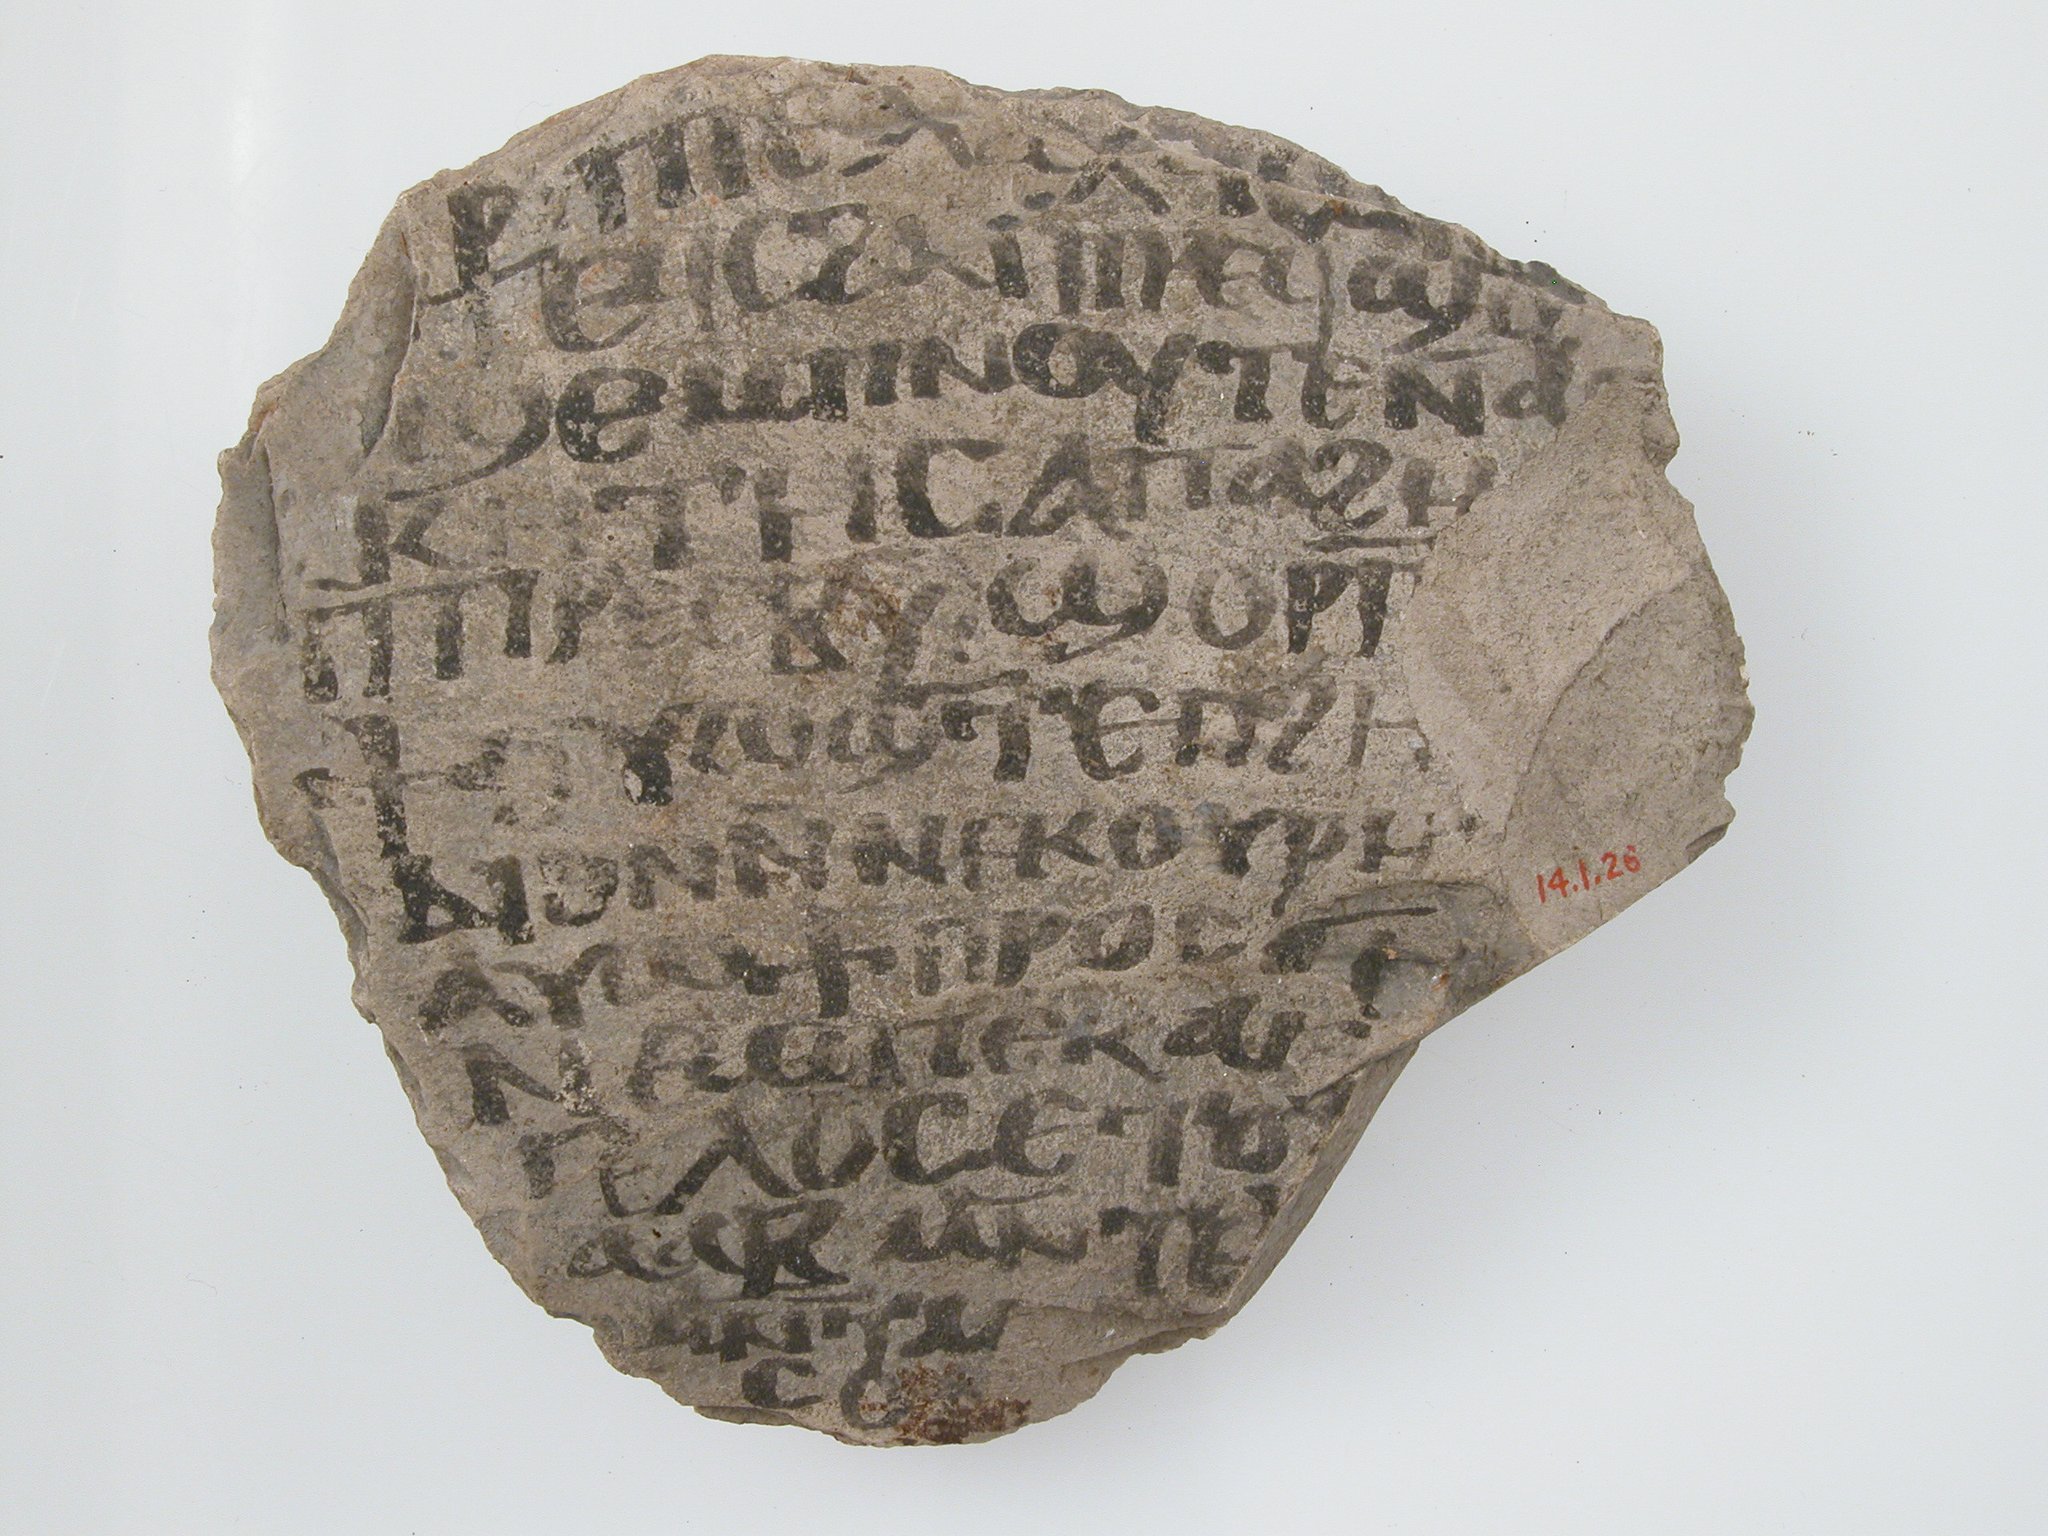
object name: ostrakon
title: Ostrakon with a Letter from Jonah to Elias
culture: coptic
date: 600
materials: ink, limestone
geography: egypt